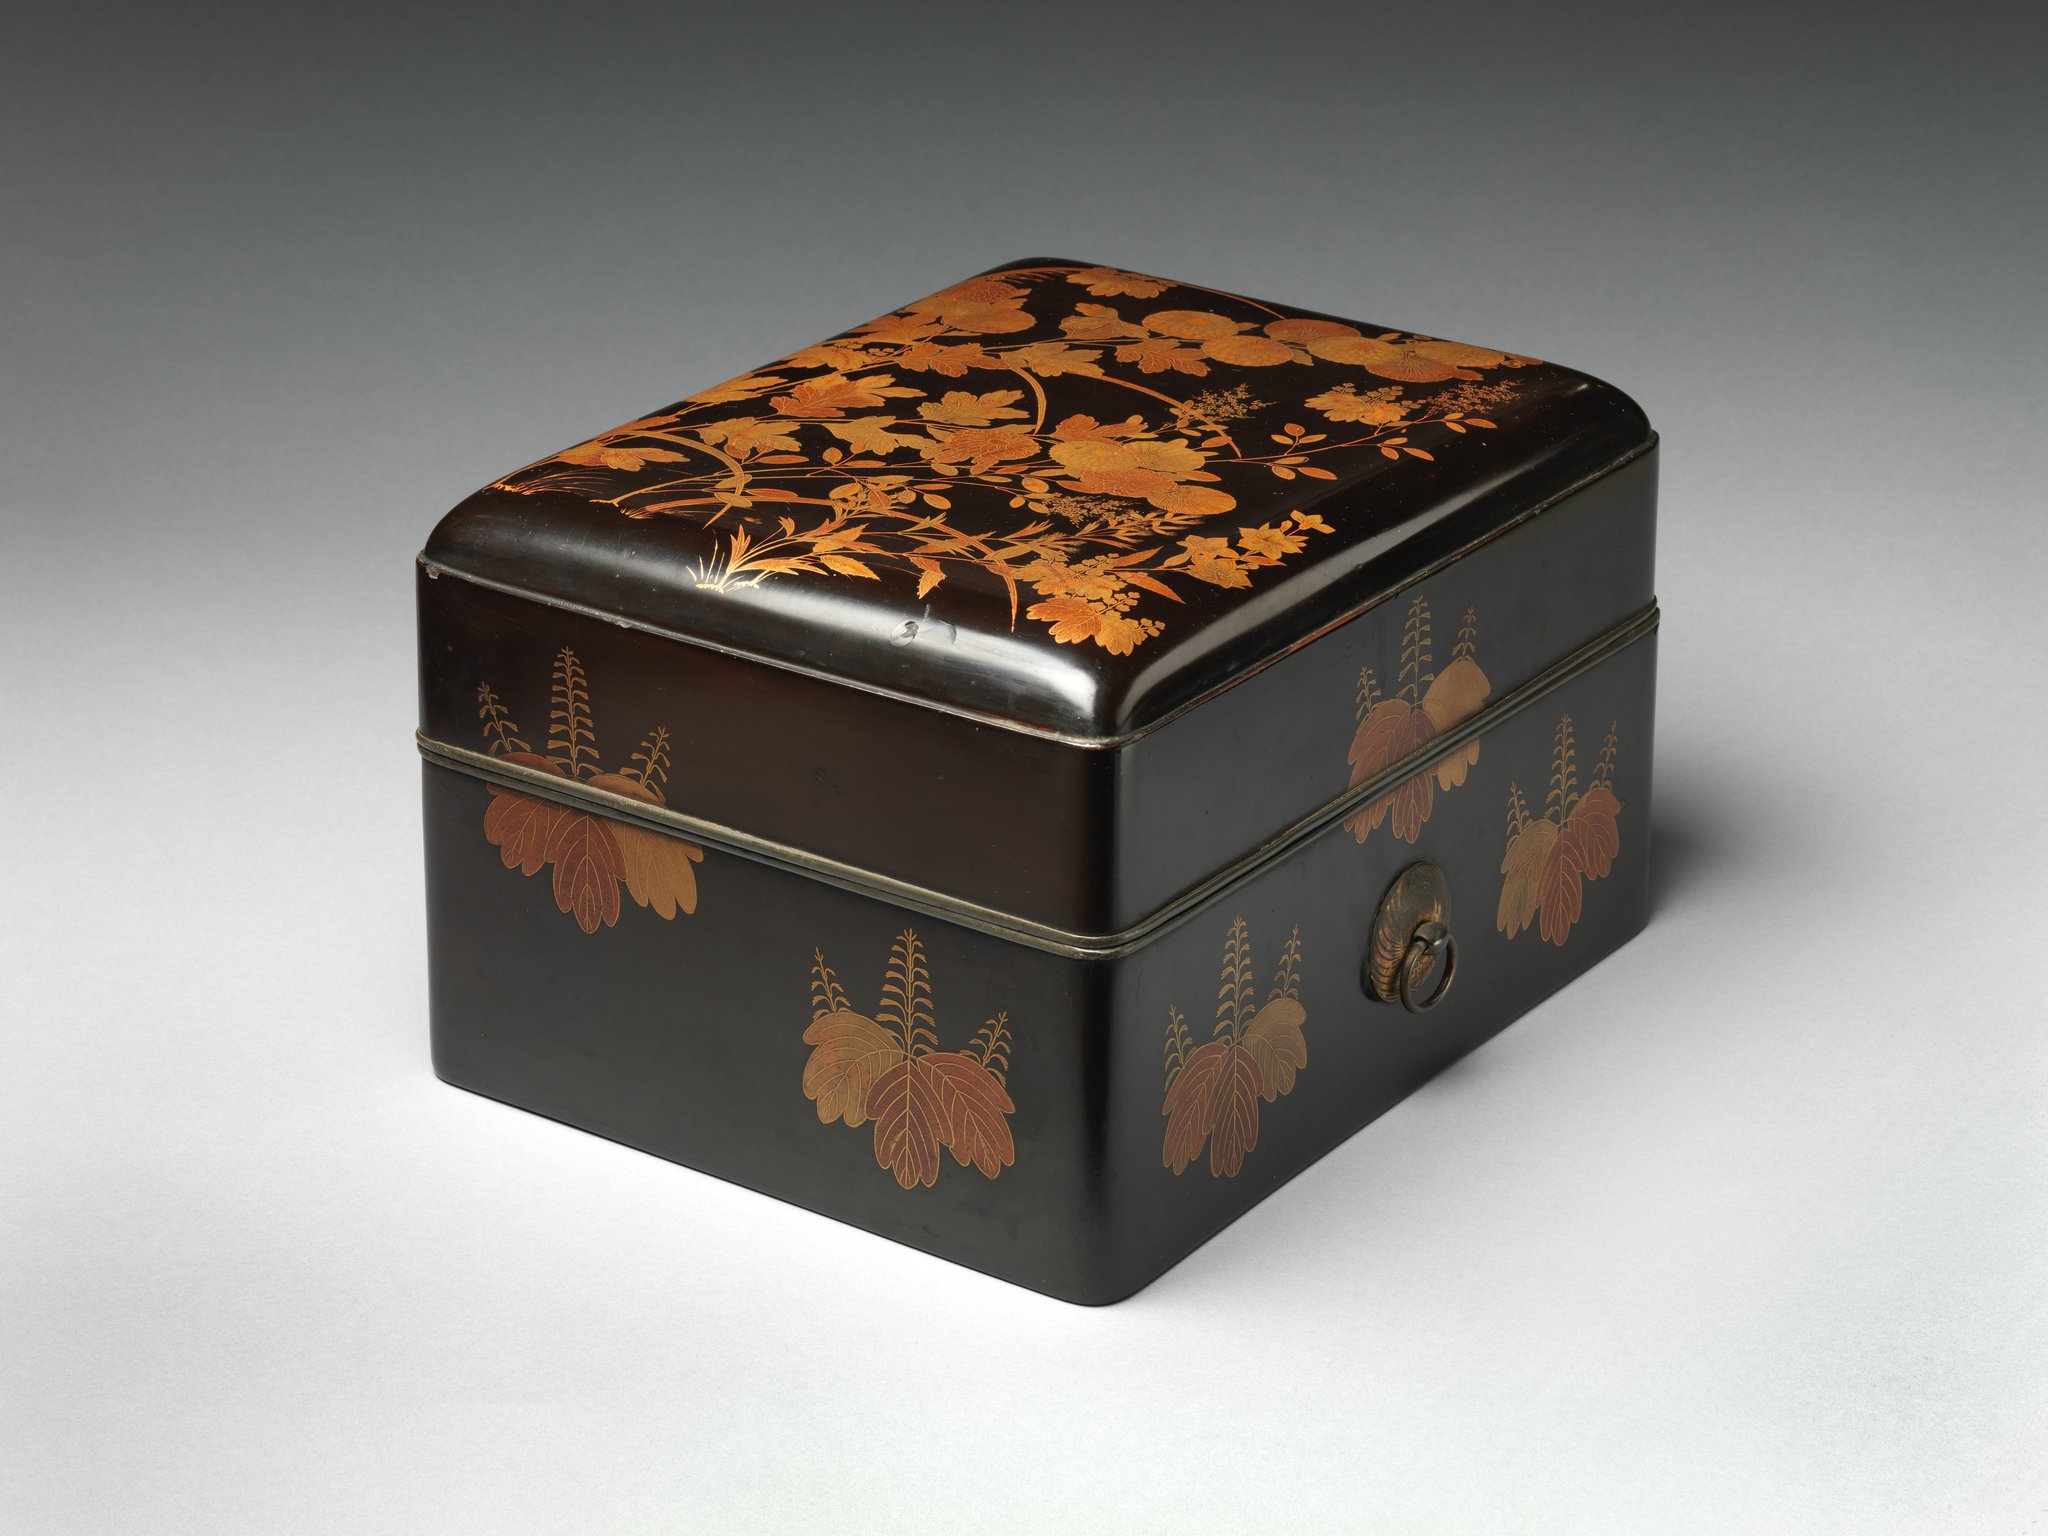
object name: box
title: Box for Personal Accessories (Tebako) with Autumn Grasses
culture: japanese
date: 1601-1633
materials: gold, silver, wood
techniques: hiramakie, lacquer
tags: flowers